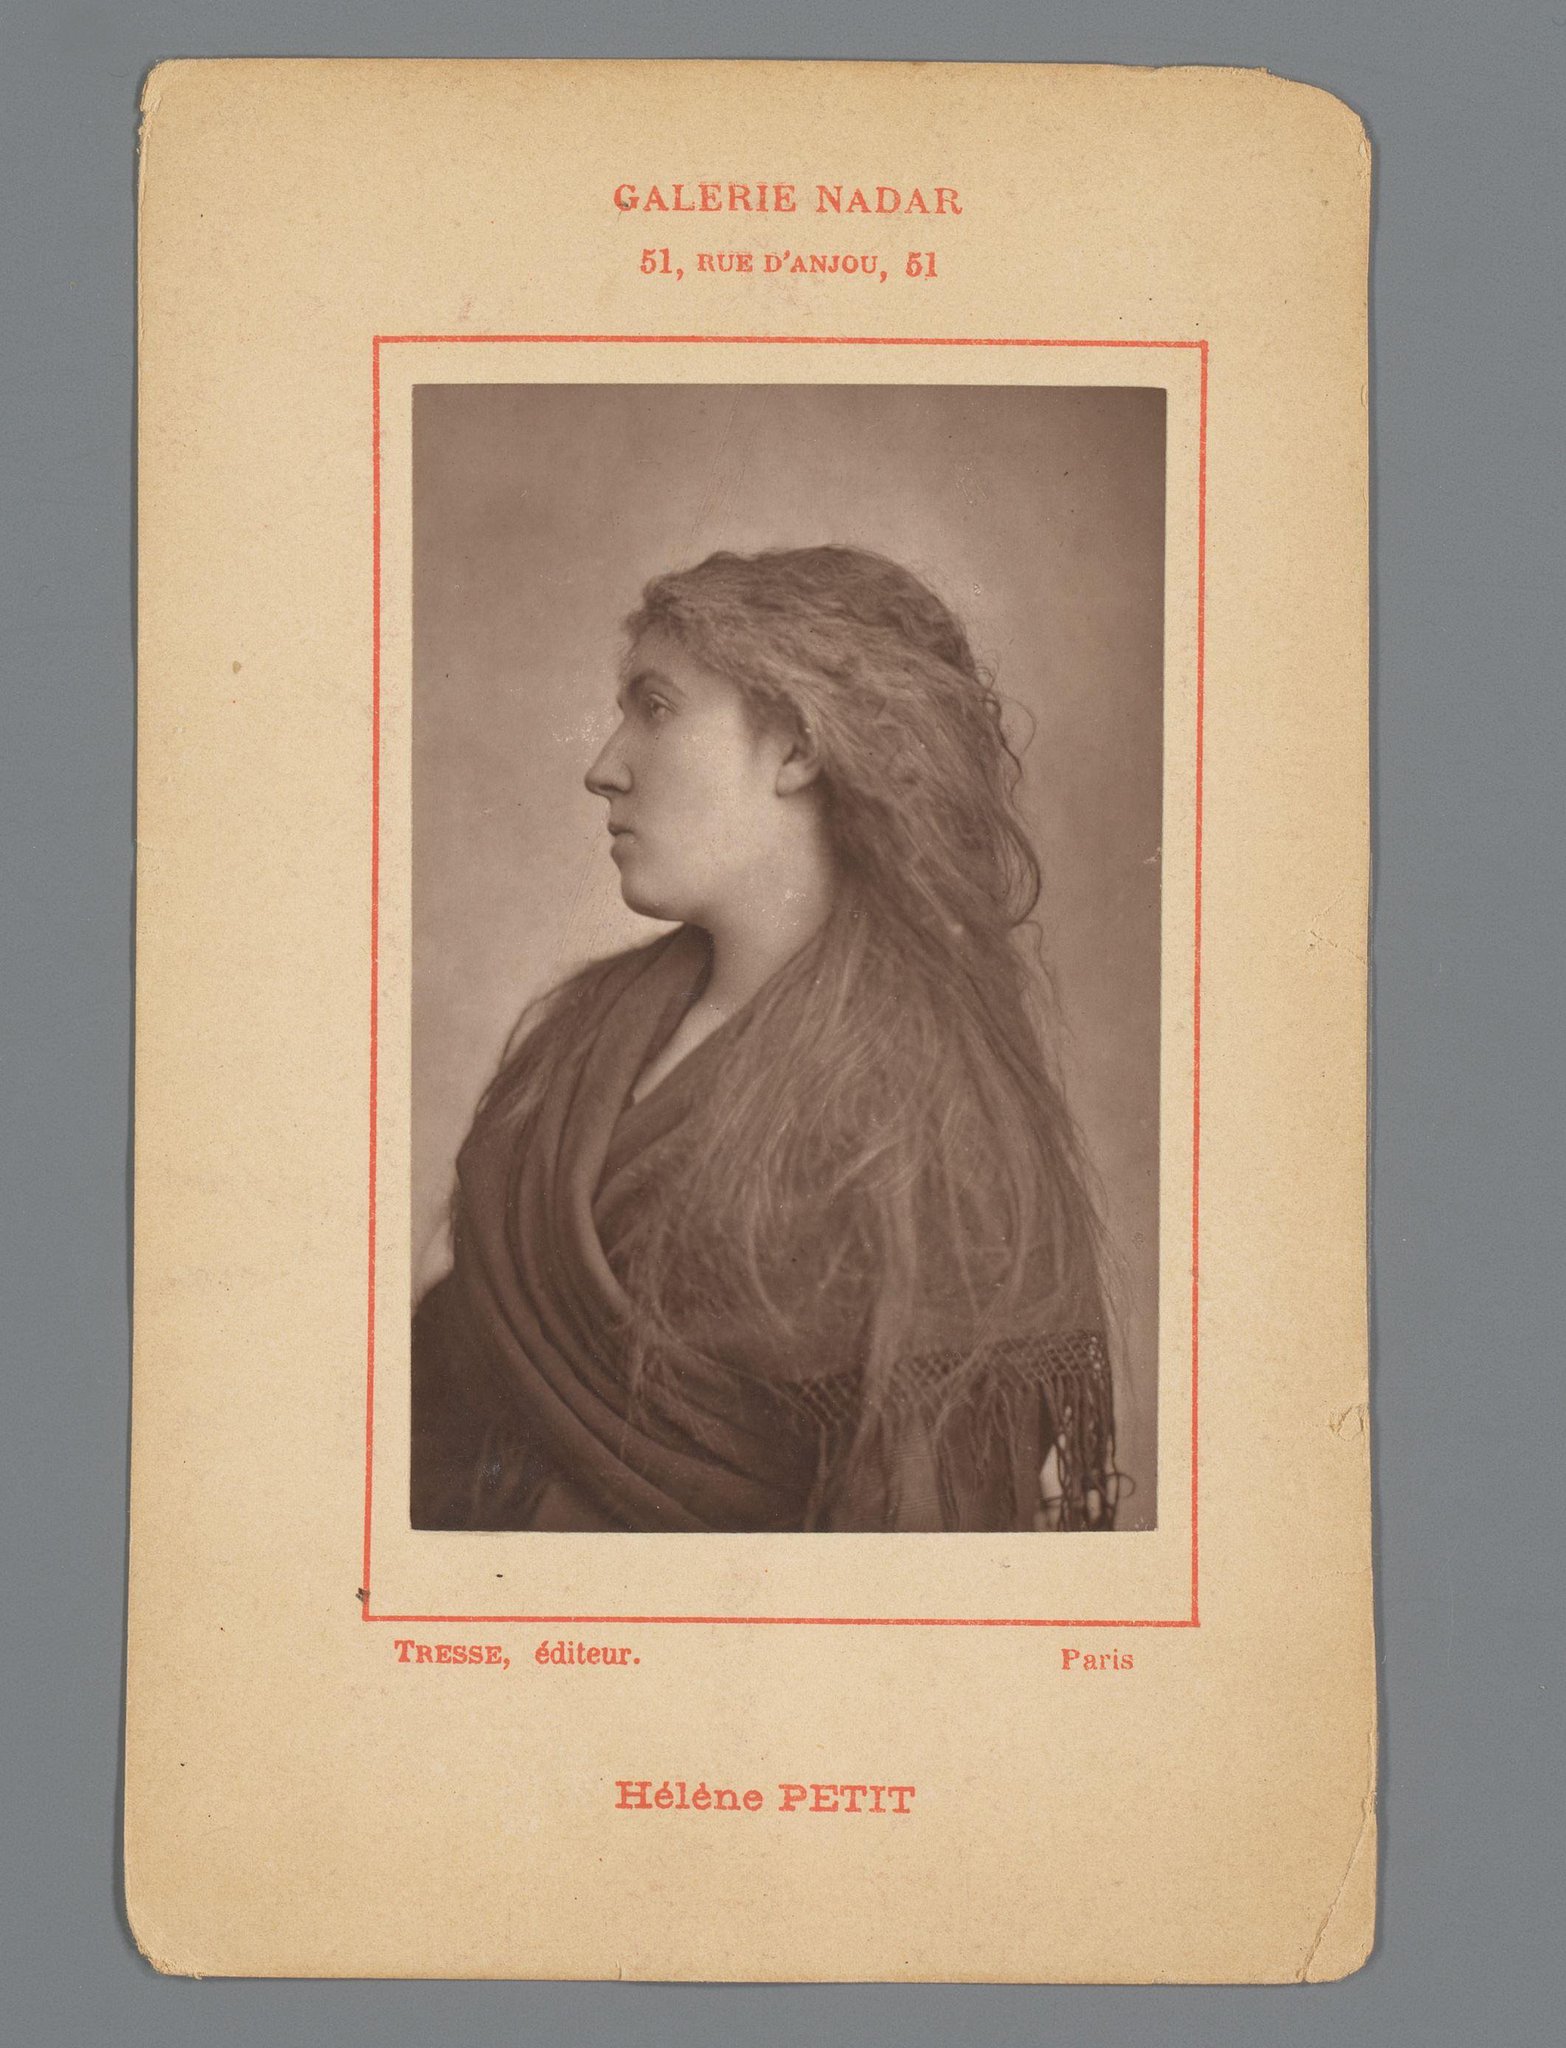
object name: cabinet photograph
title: Portret van Hélène Petit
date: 1873-1880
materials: paper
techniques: albumen print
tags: portrait of actor, actress, france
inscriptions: inscription: ‘GALERIE NADAR/ 51, RUE D'ANJOU, 51/ TRESSE, éditeur./ Paris’